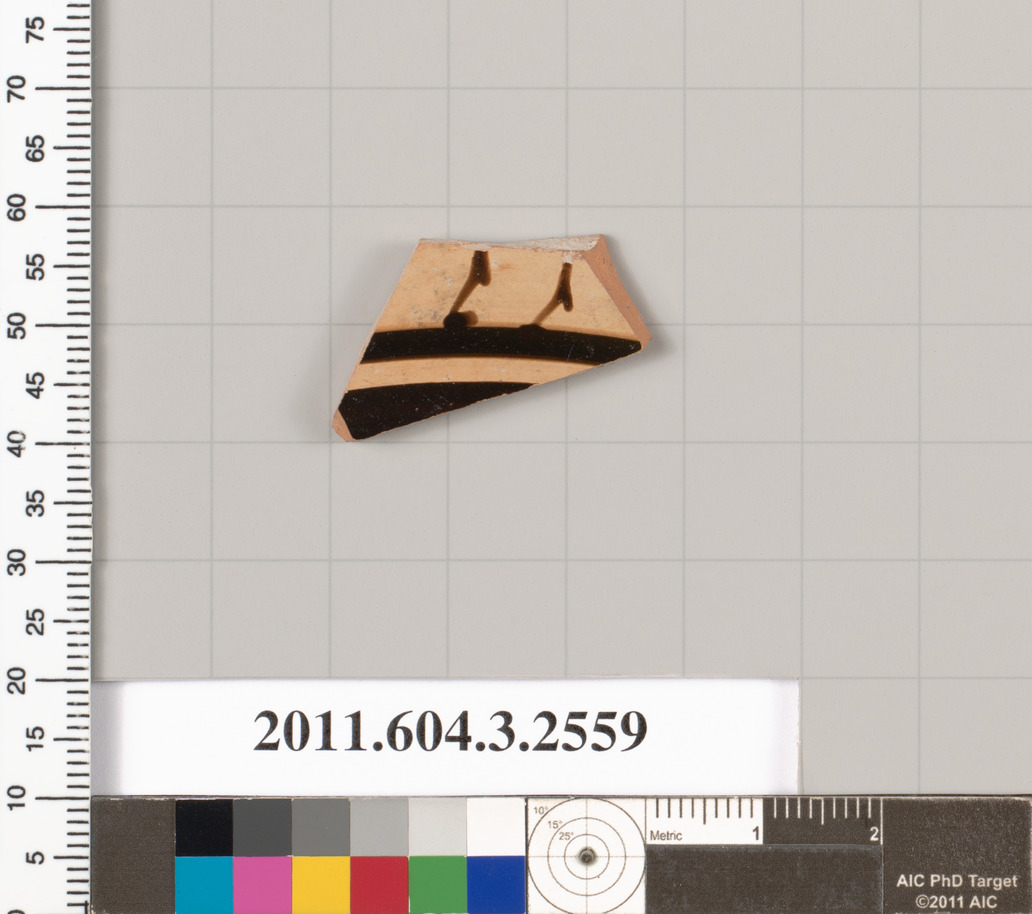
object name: kylix fragment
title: Terracotta fragment of a kylix (drinking cup)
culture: greek, attic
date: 534-468 BCE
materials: terracotta